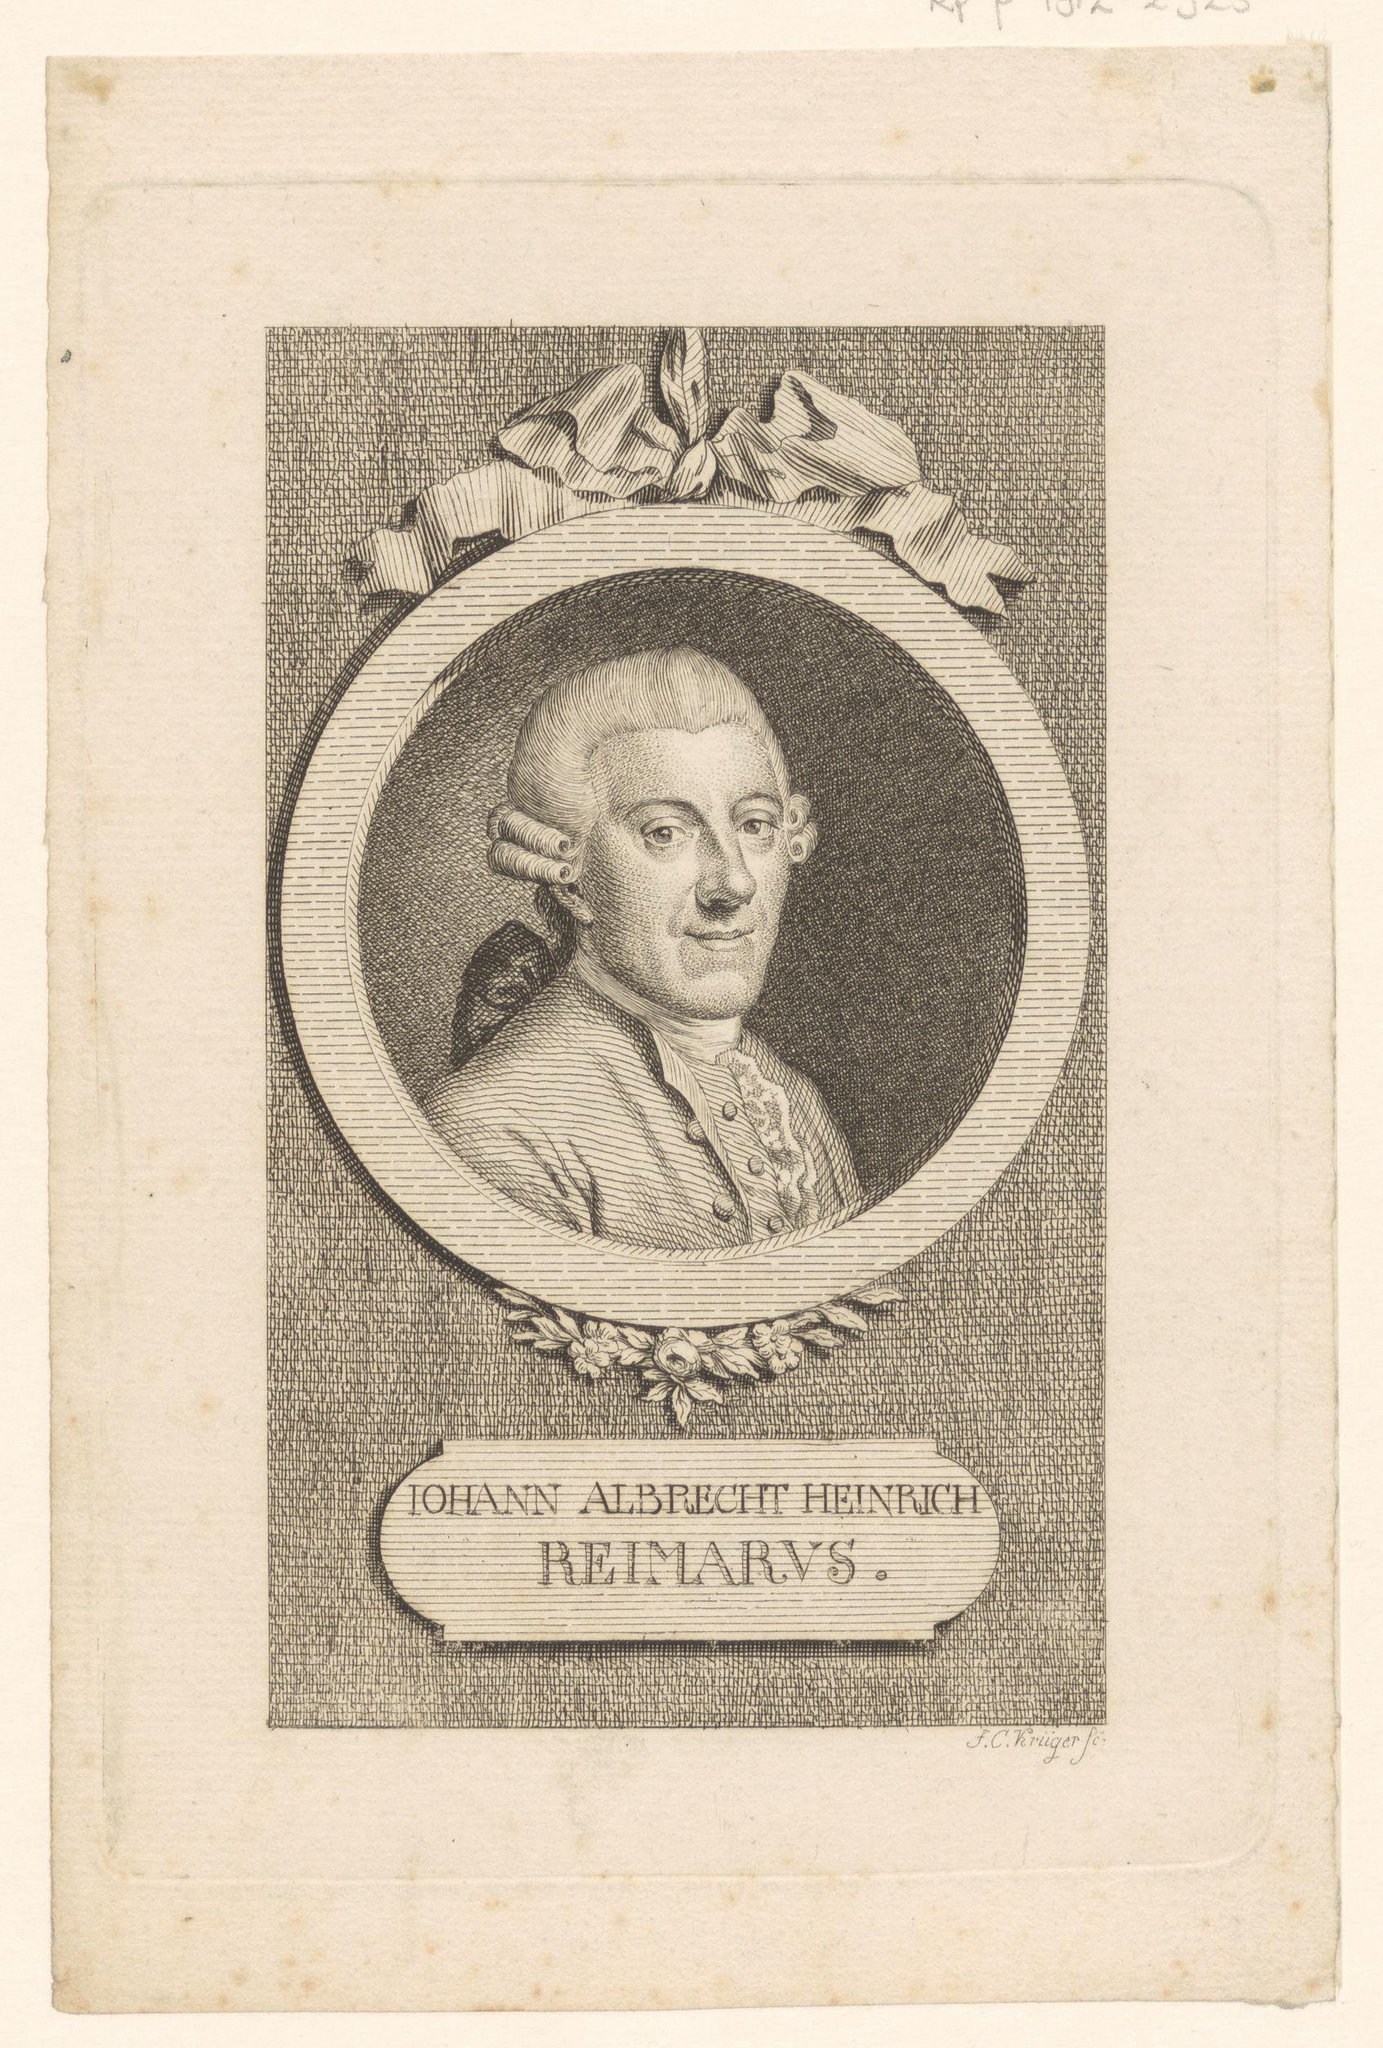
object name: print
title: Portret van Johann Albert Heinrich Reimarus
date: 1784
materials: paper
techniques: engraving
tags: historical persons, physician, doctor (+ portrait of scholar, scientist)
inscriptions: collector's mark: Lugt 2228